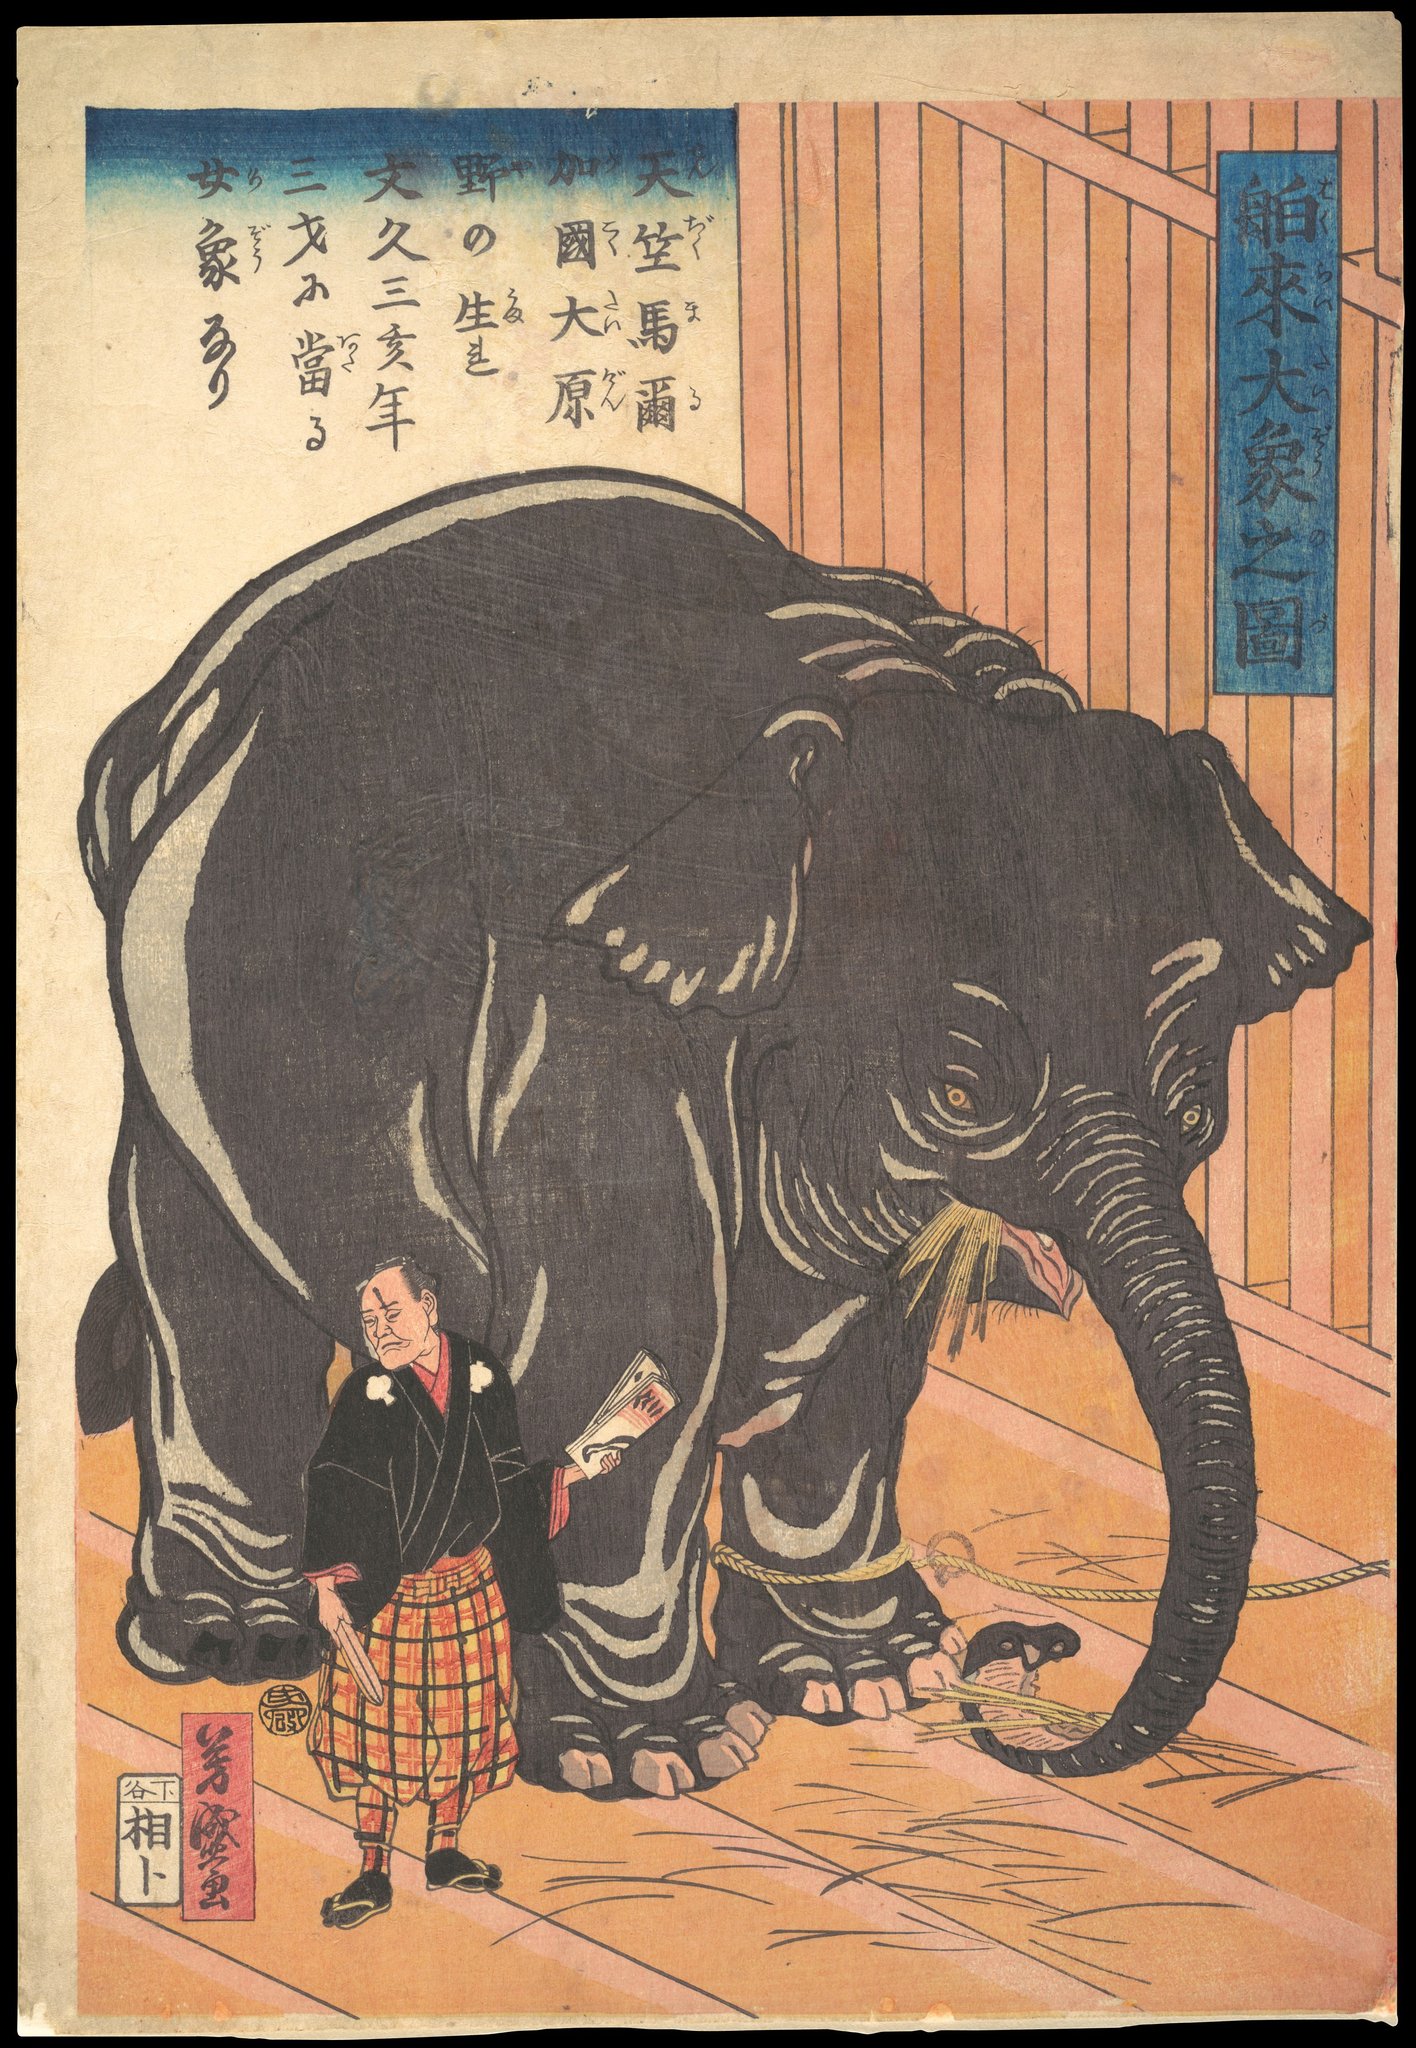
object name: woodblock print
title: View of the Large Imported Elephant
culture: japanese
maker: taguchi (utagawa) yoshimori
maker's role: artist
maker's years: 1830-1884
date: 1863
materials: ink, paper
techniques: woodblock print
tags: men,elephants